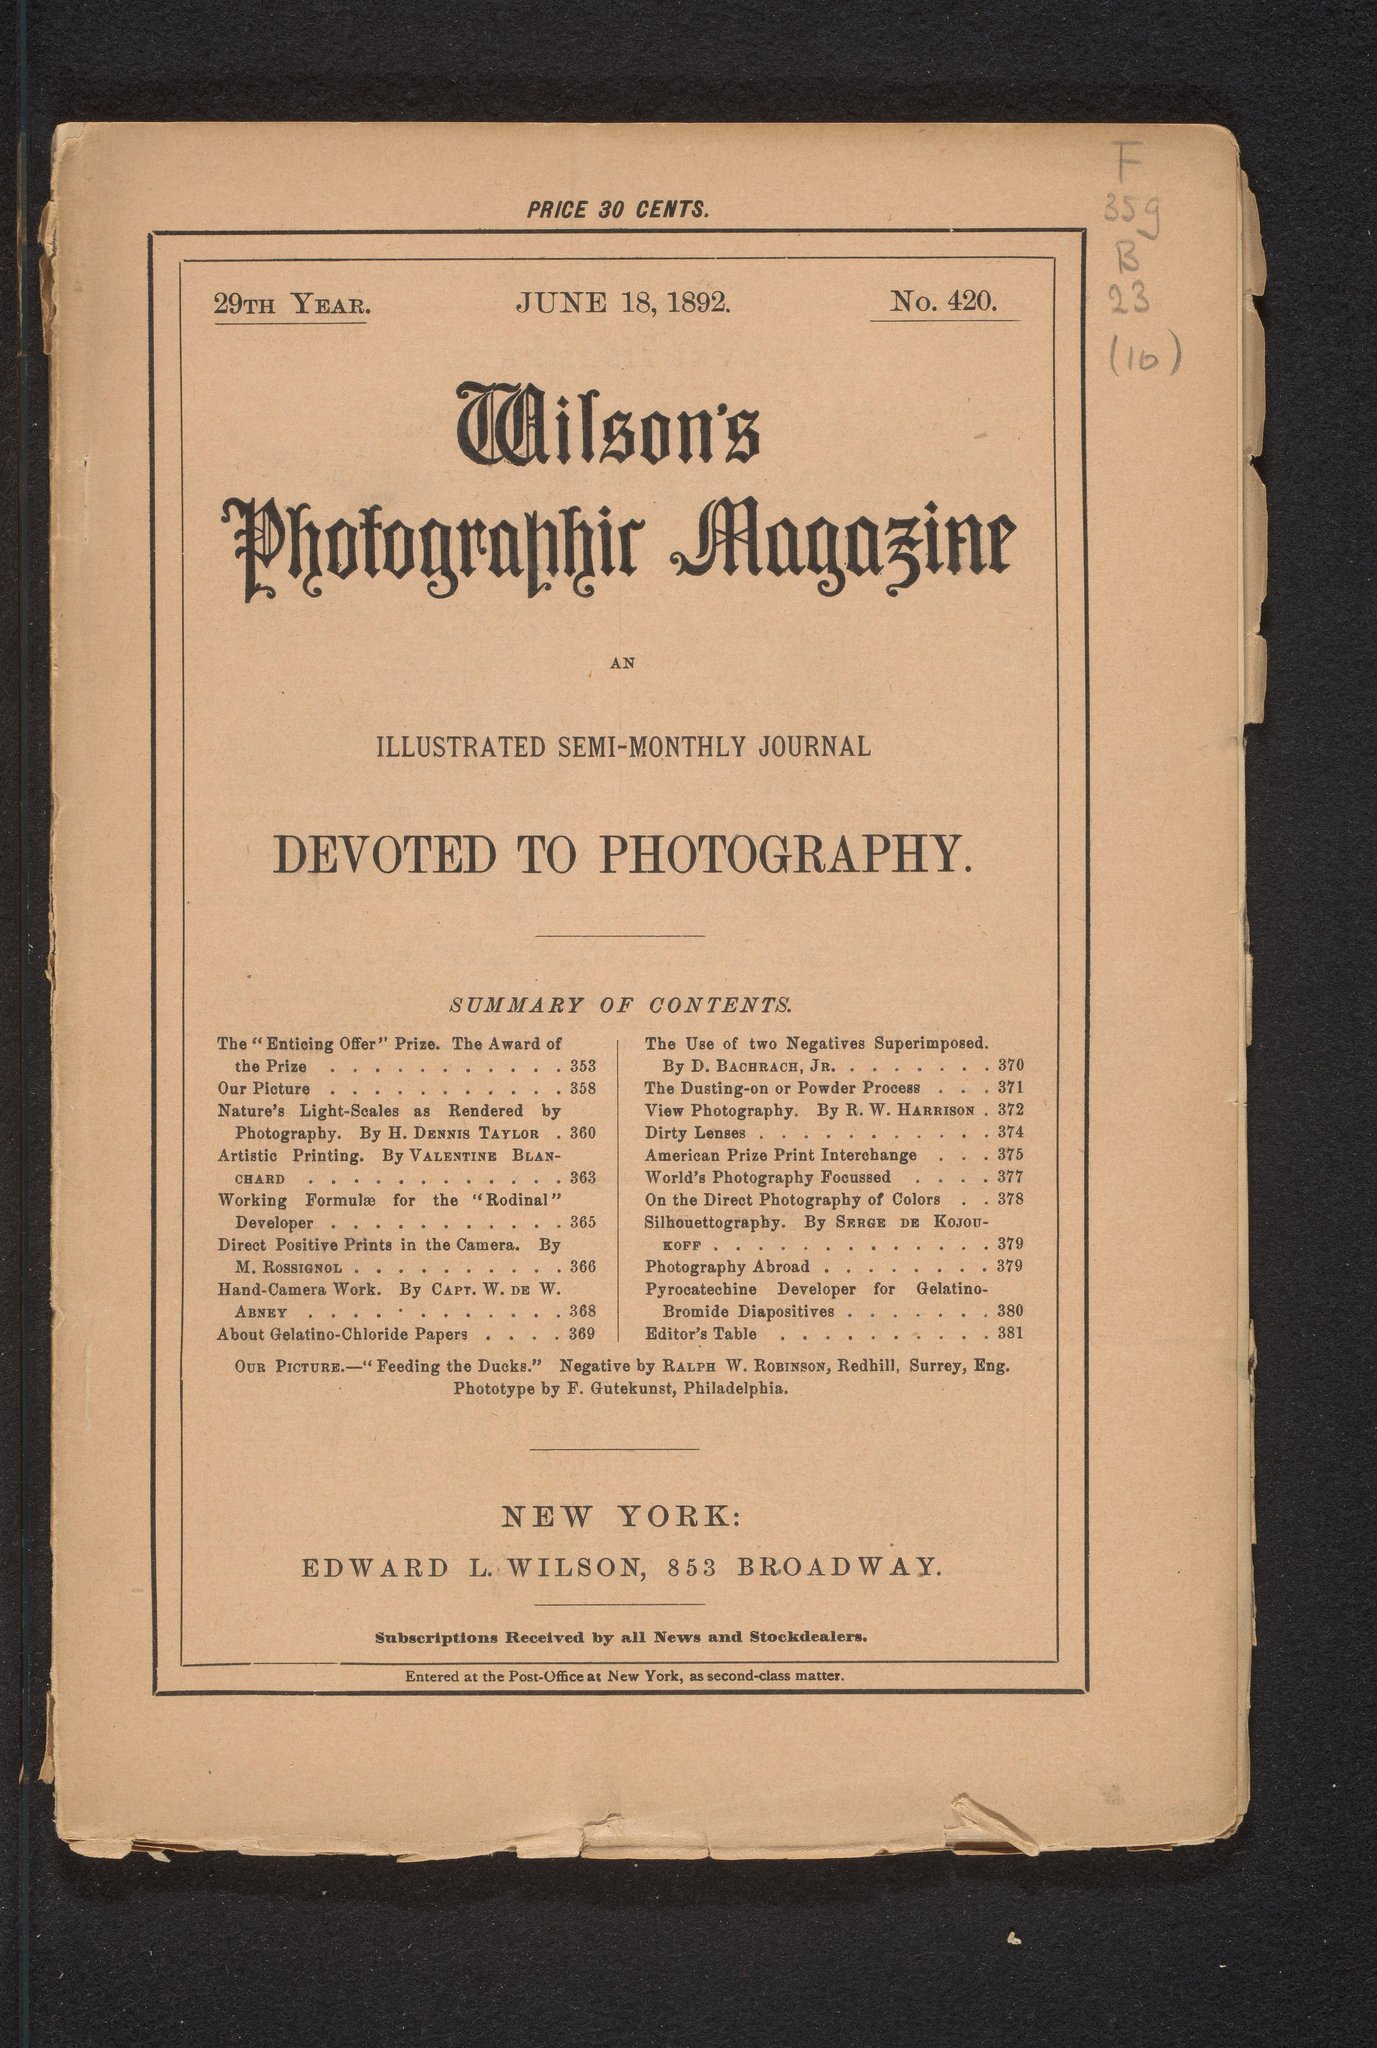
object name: magazine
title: Wilson's photographic magazine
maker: edward livingston wilson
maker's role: publisher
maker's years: 1838-1903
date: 1892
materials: paper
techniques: photograph, printing, engraving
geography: new york city